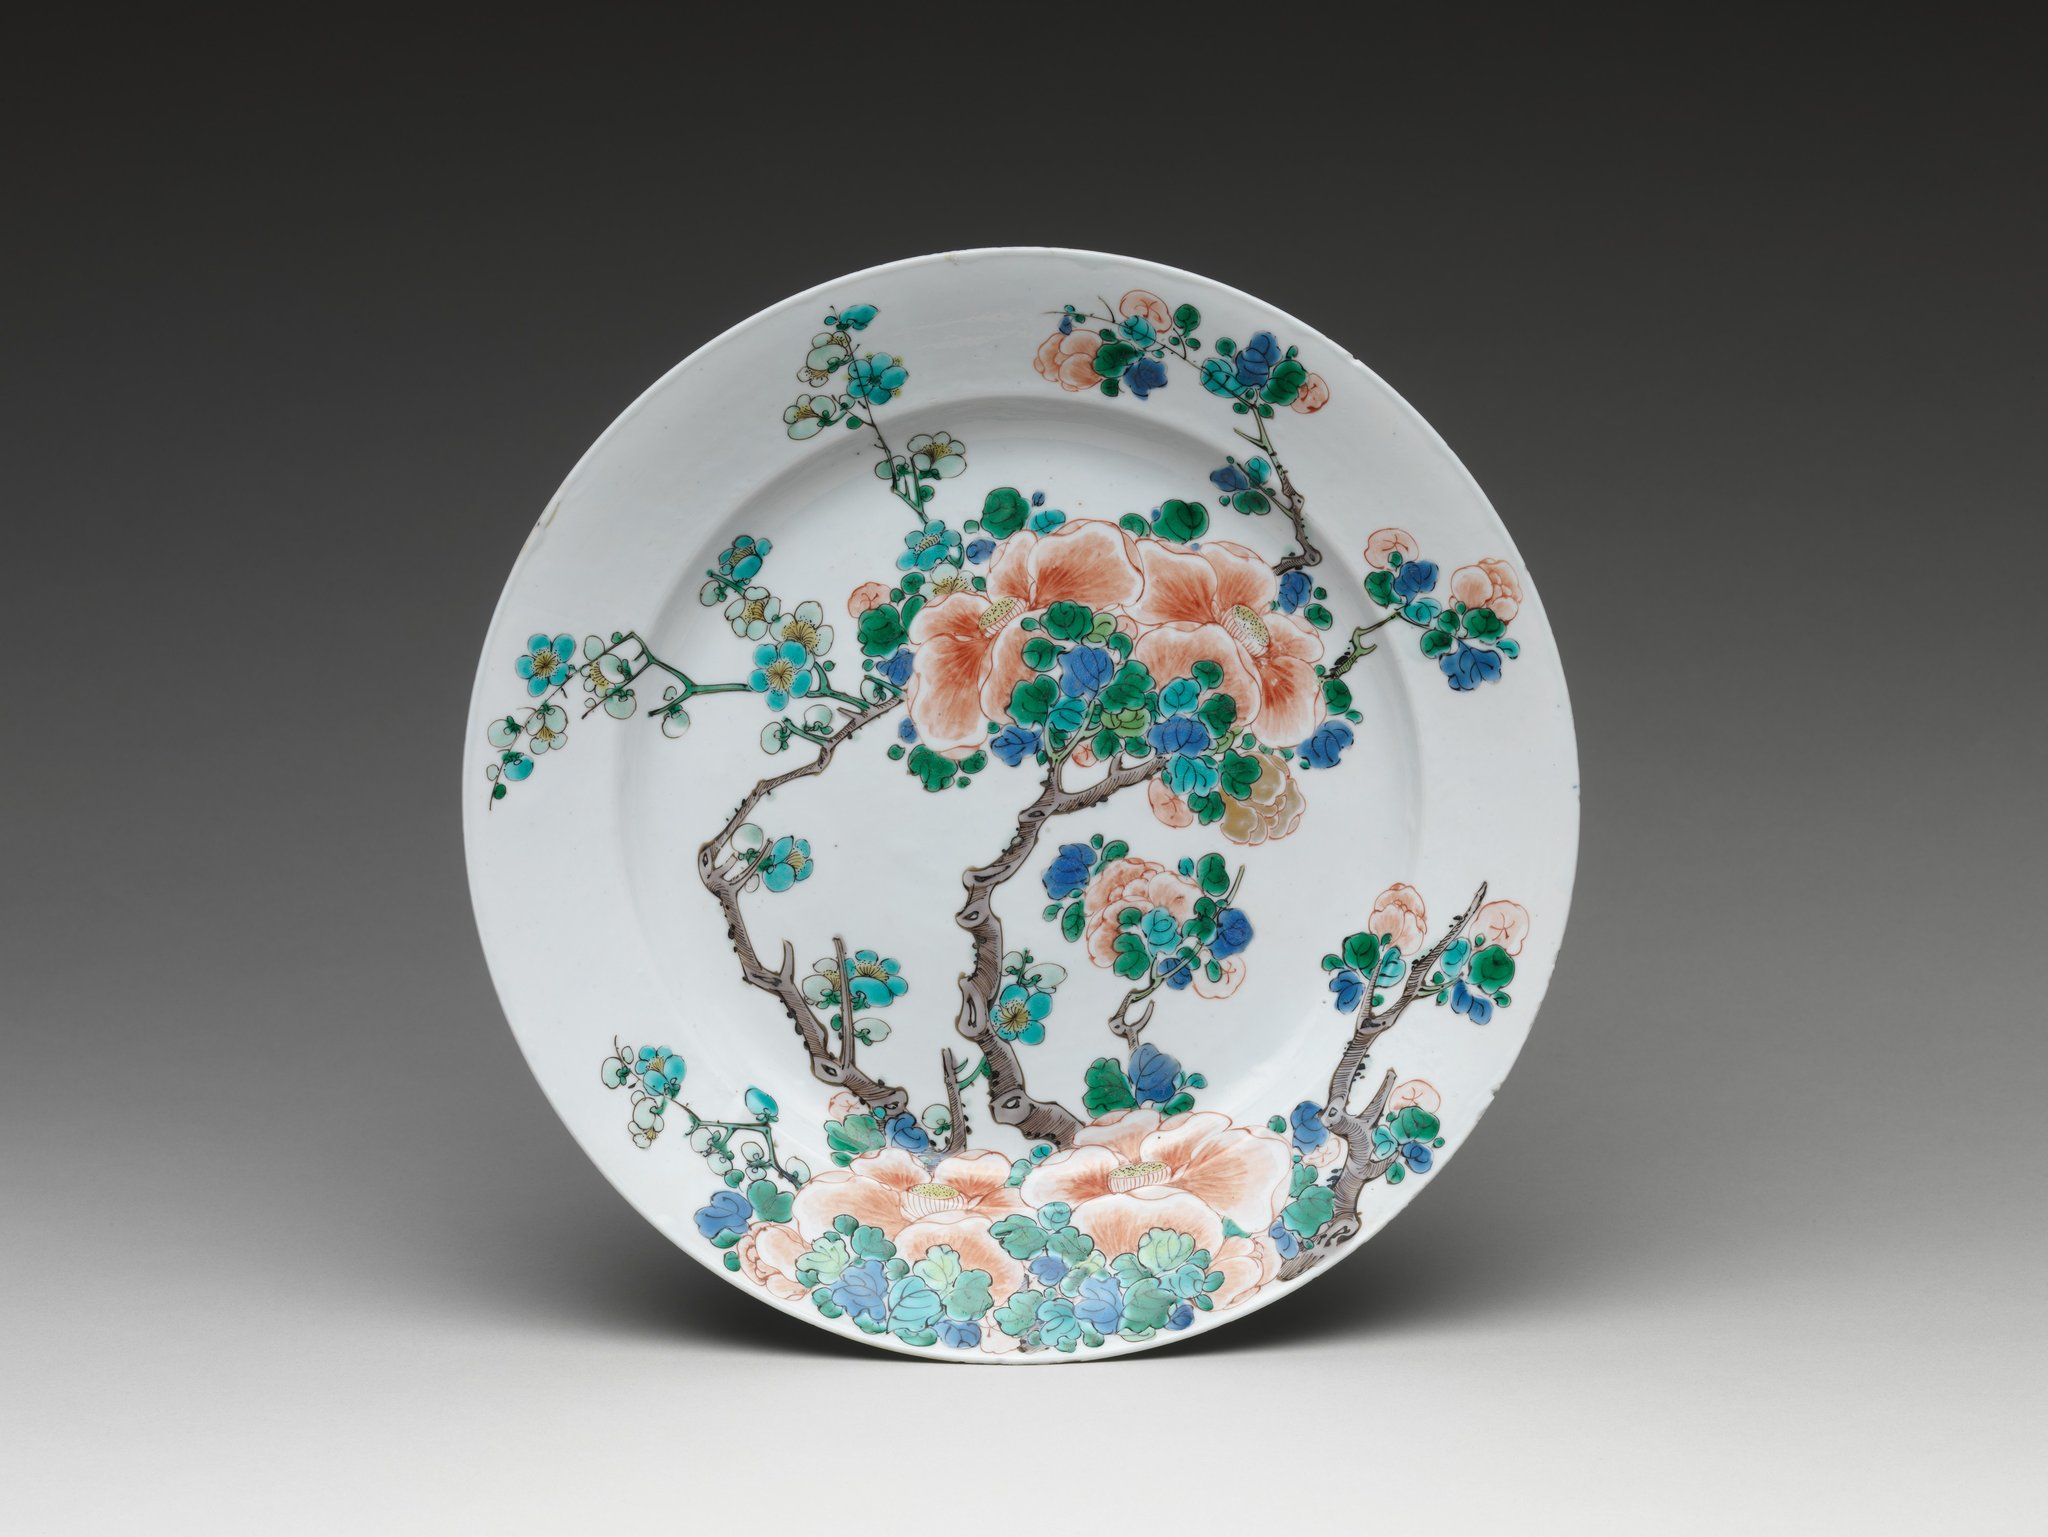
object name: dish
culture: chinese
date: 1720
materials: enamel, porcelain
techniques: overglaze, painting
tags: flowers,trees